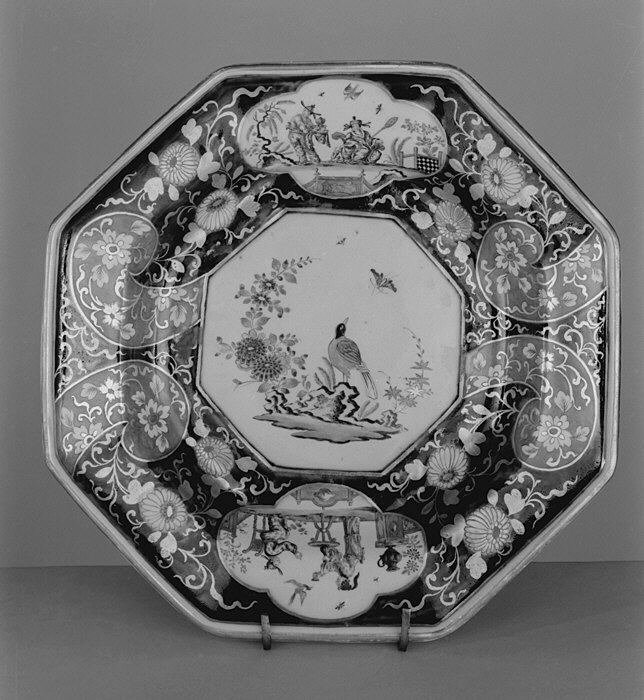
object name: plate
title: Plate (one of a pair)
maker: imperial porcelain manufactory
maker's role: manufactory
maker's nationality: austrian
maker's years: 1744-1864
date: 1750-1755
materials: hard paste porcelain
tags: birds,flowers